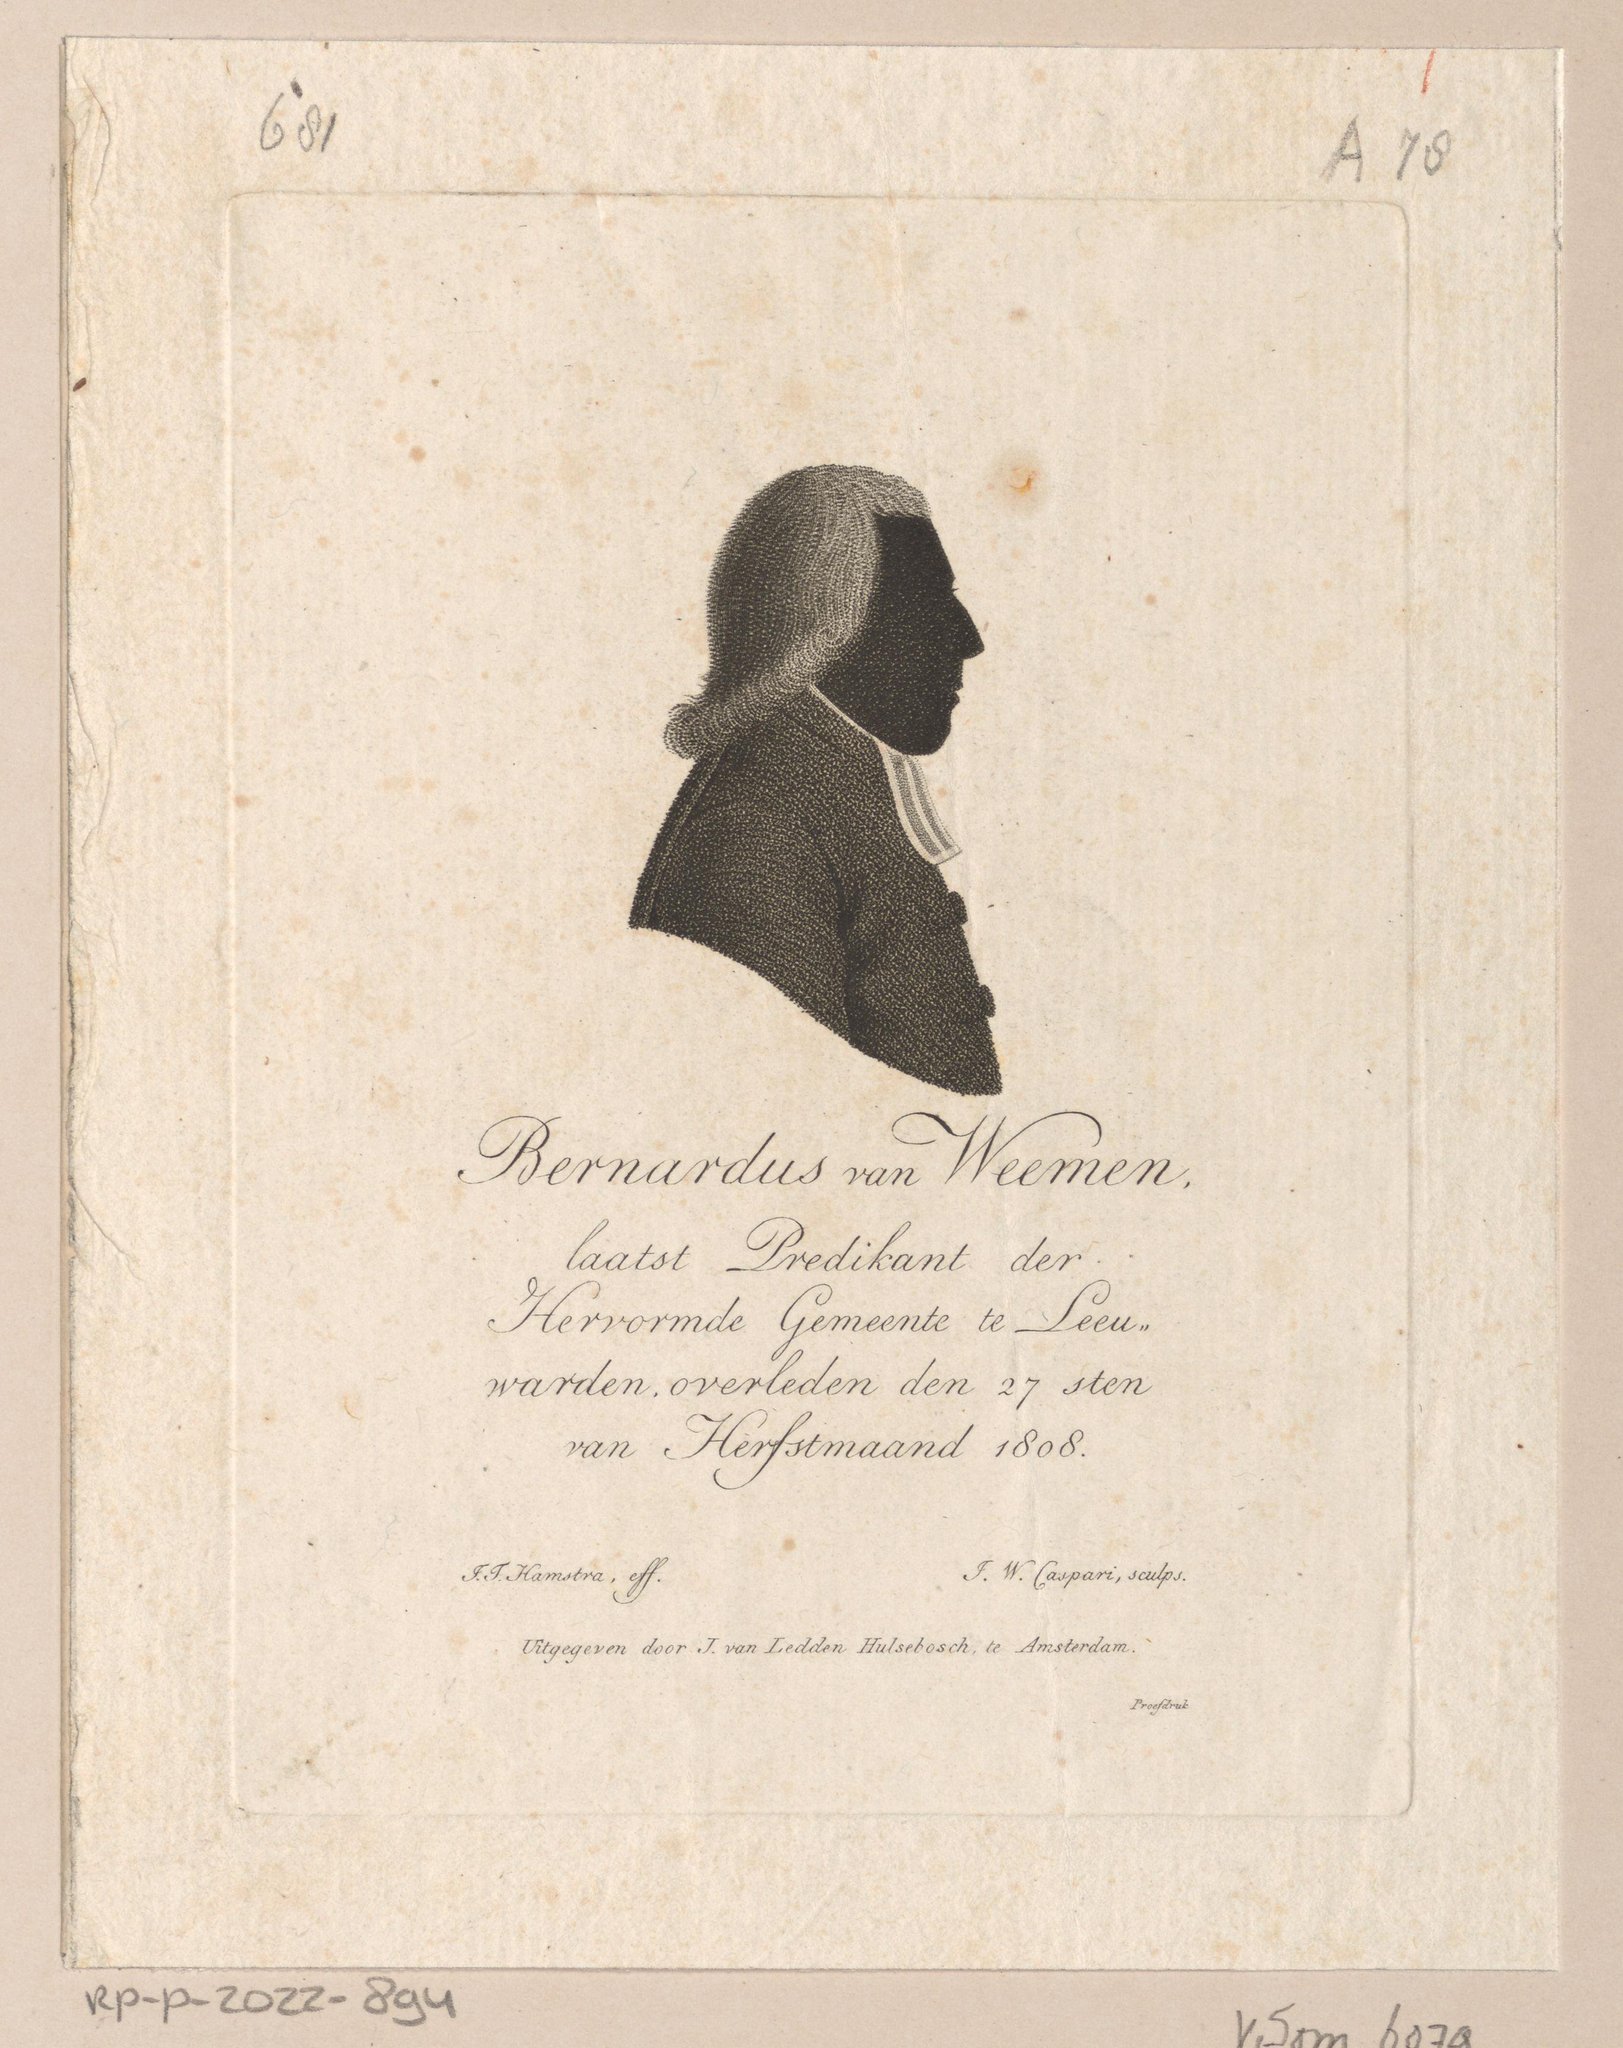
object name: print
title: Silhouetportret van Bernardus van Weemen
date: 1808-1822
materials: paper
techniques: etching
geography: amsterdam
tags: functionaries and dignitaries (with name) ~ protestant churches, historical persons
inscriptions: number: ‘681’, collector's mark: Lugt 2233, number: ‘A78’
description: Met vijfregelig onderschrift in het Nederlands.